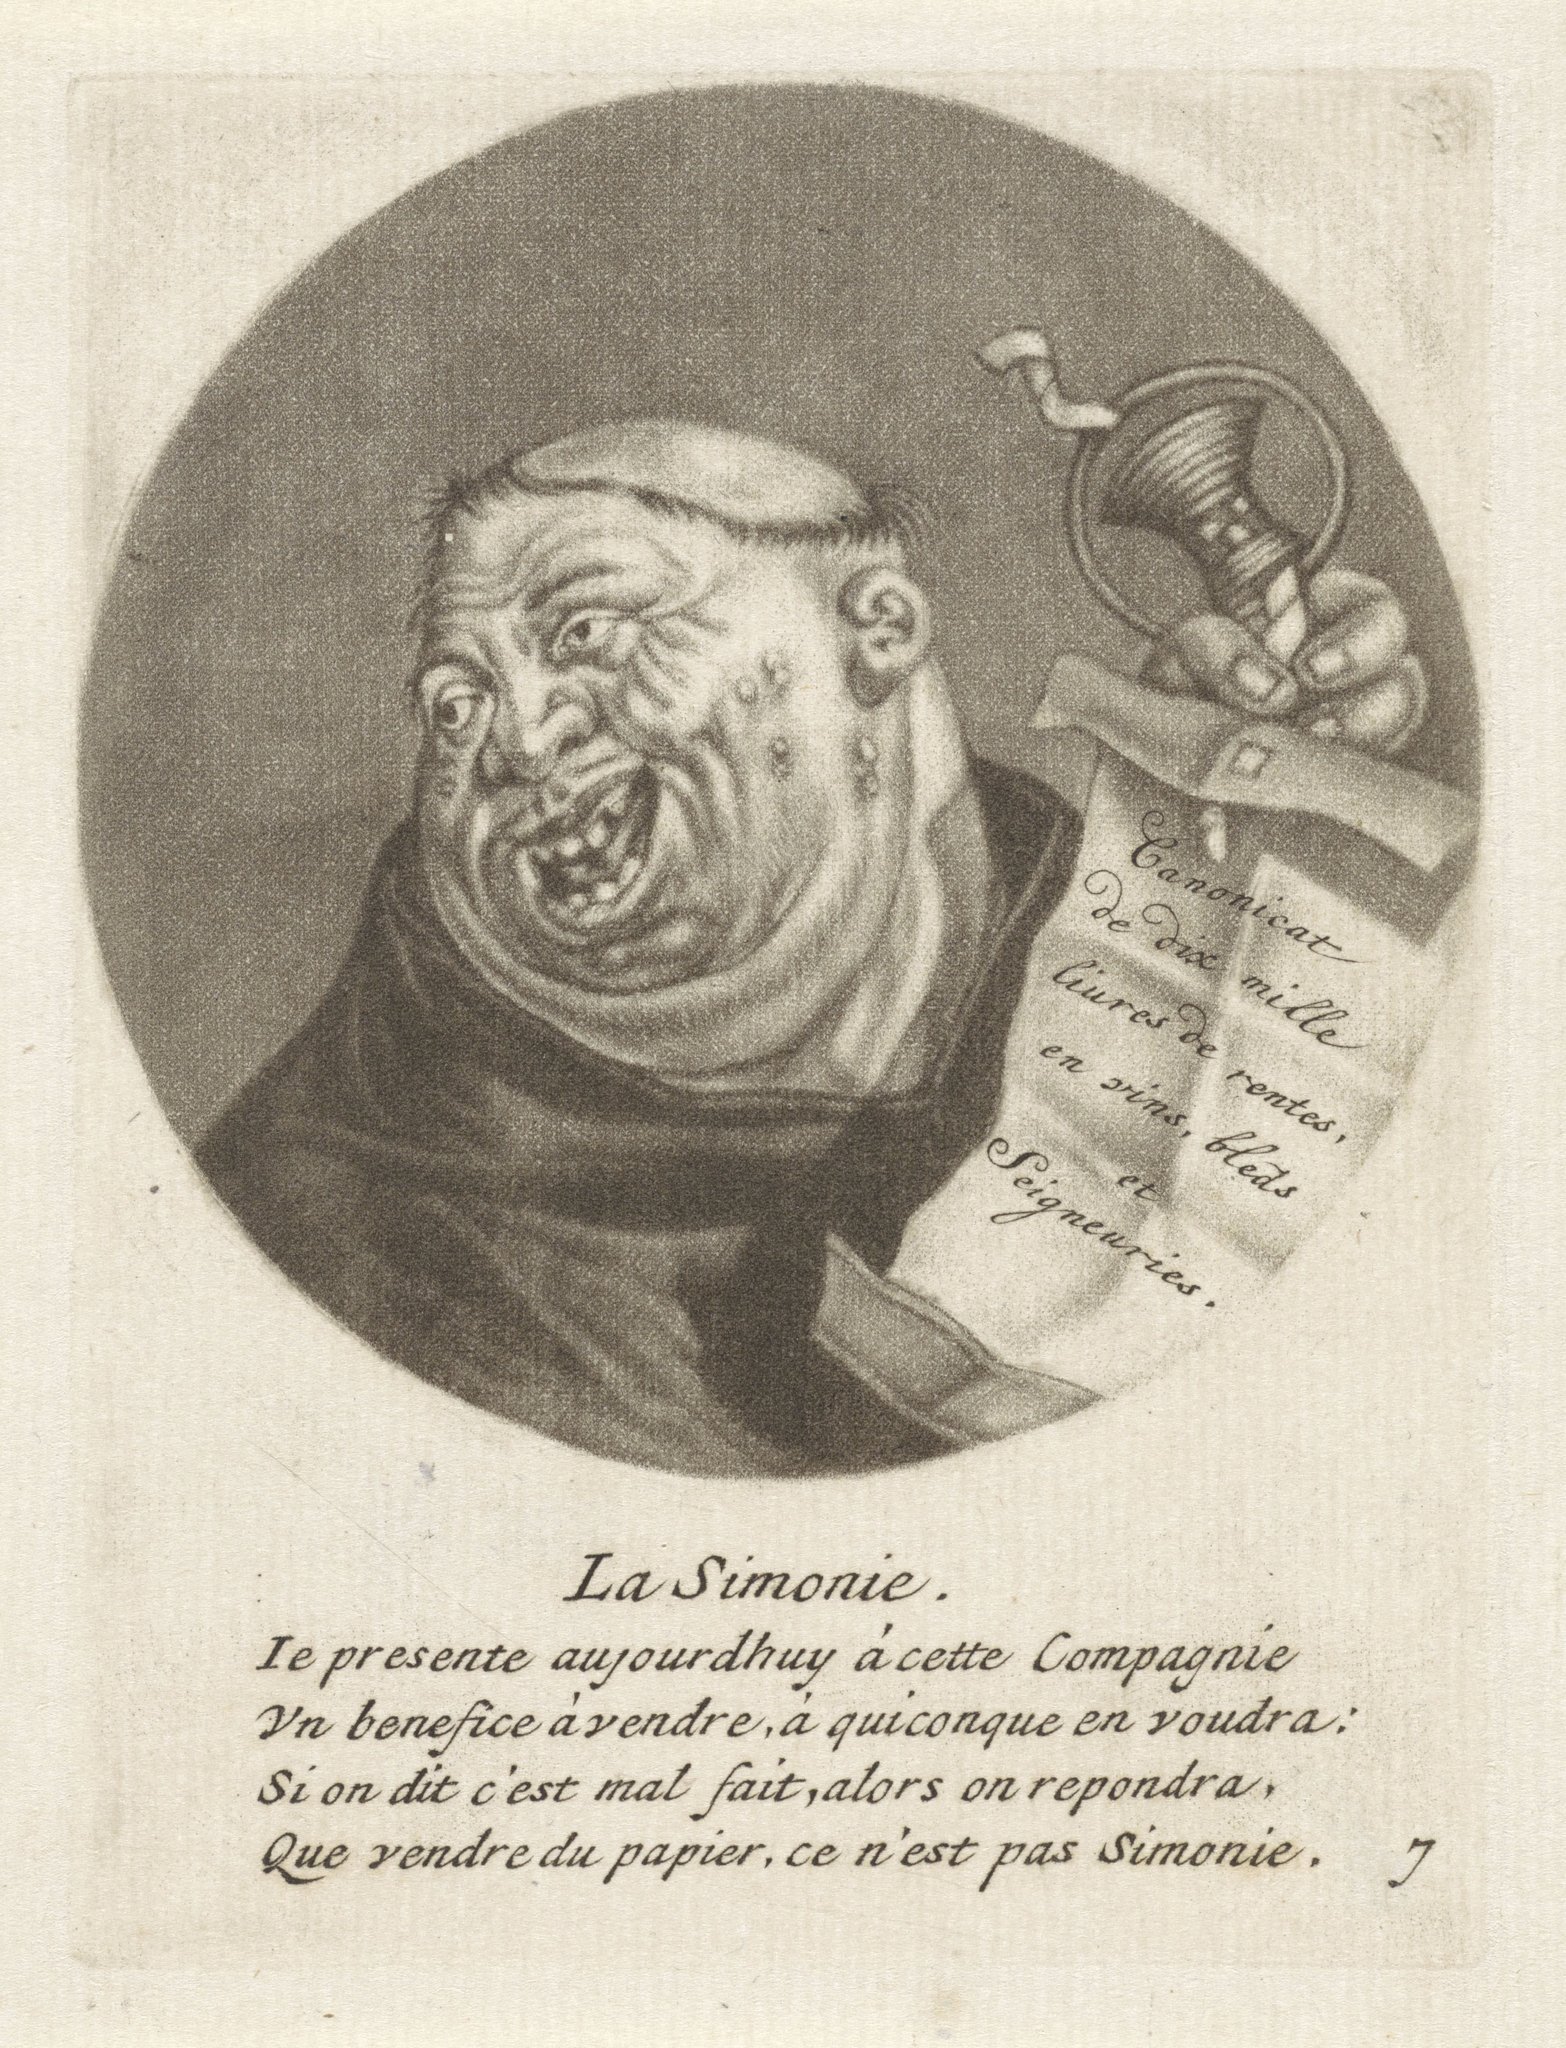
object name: print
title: Karikaturen op de Franse geestelijkheid onder Lodewijk XIV, (B)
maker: jacob gole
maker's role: print maker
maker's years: 1660-1724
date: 1670-1724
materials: paper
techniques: engraving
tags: monk(s), friar(s), abuses of the clergy, e.g. simony, political caricatures and satires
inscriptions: collector's mark: Lugt 2228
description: Spotprent op de simonie. Een monnik presenteert een rol papier waarop zijn kanonikaat staat. De prent maakt deel uit van een serie met karikaturen van de Franse geestelijkheid onder Lodewijk XIV.